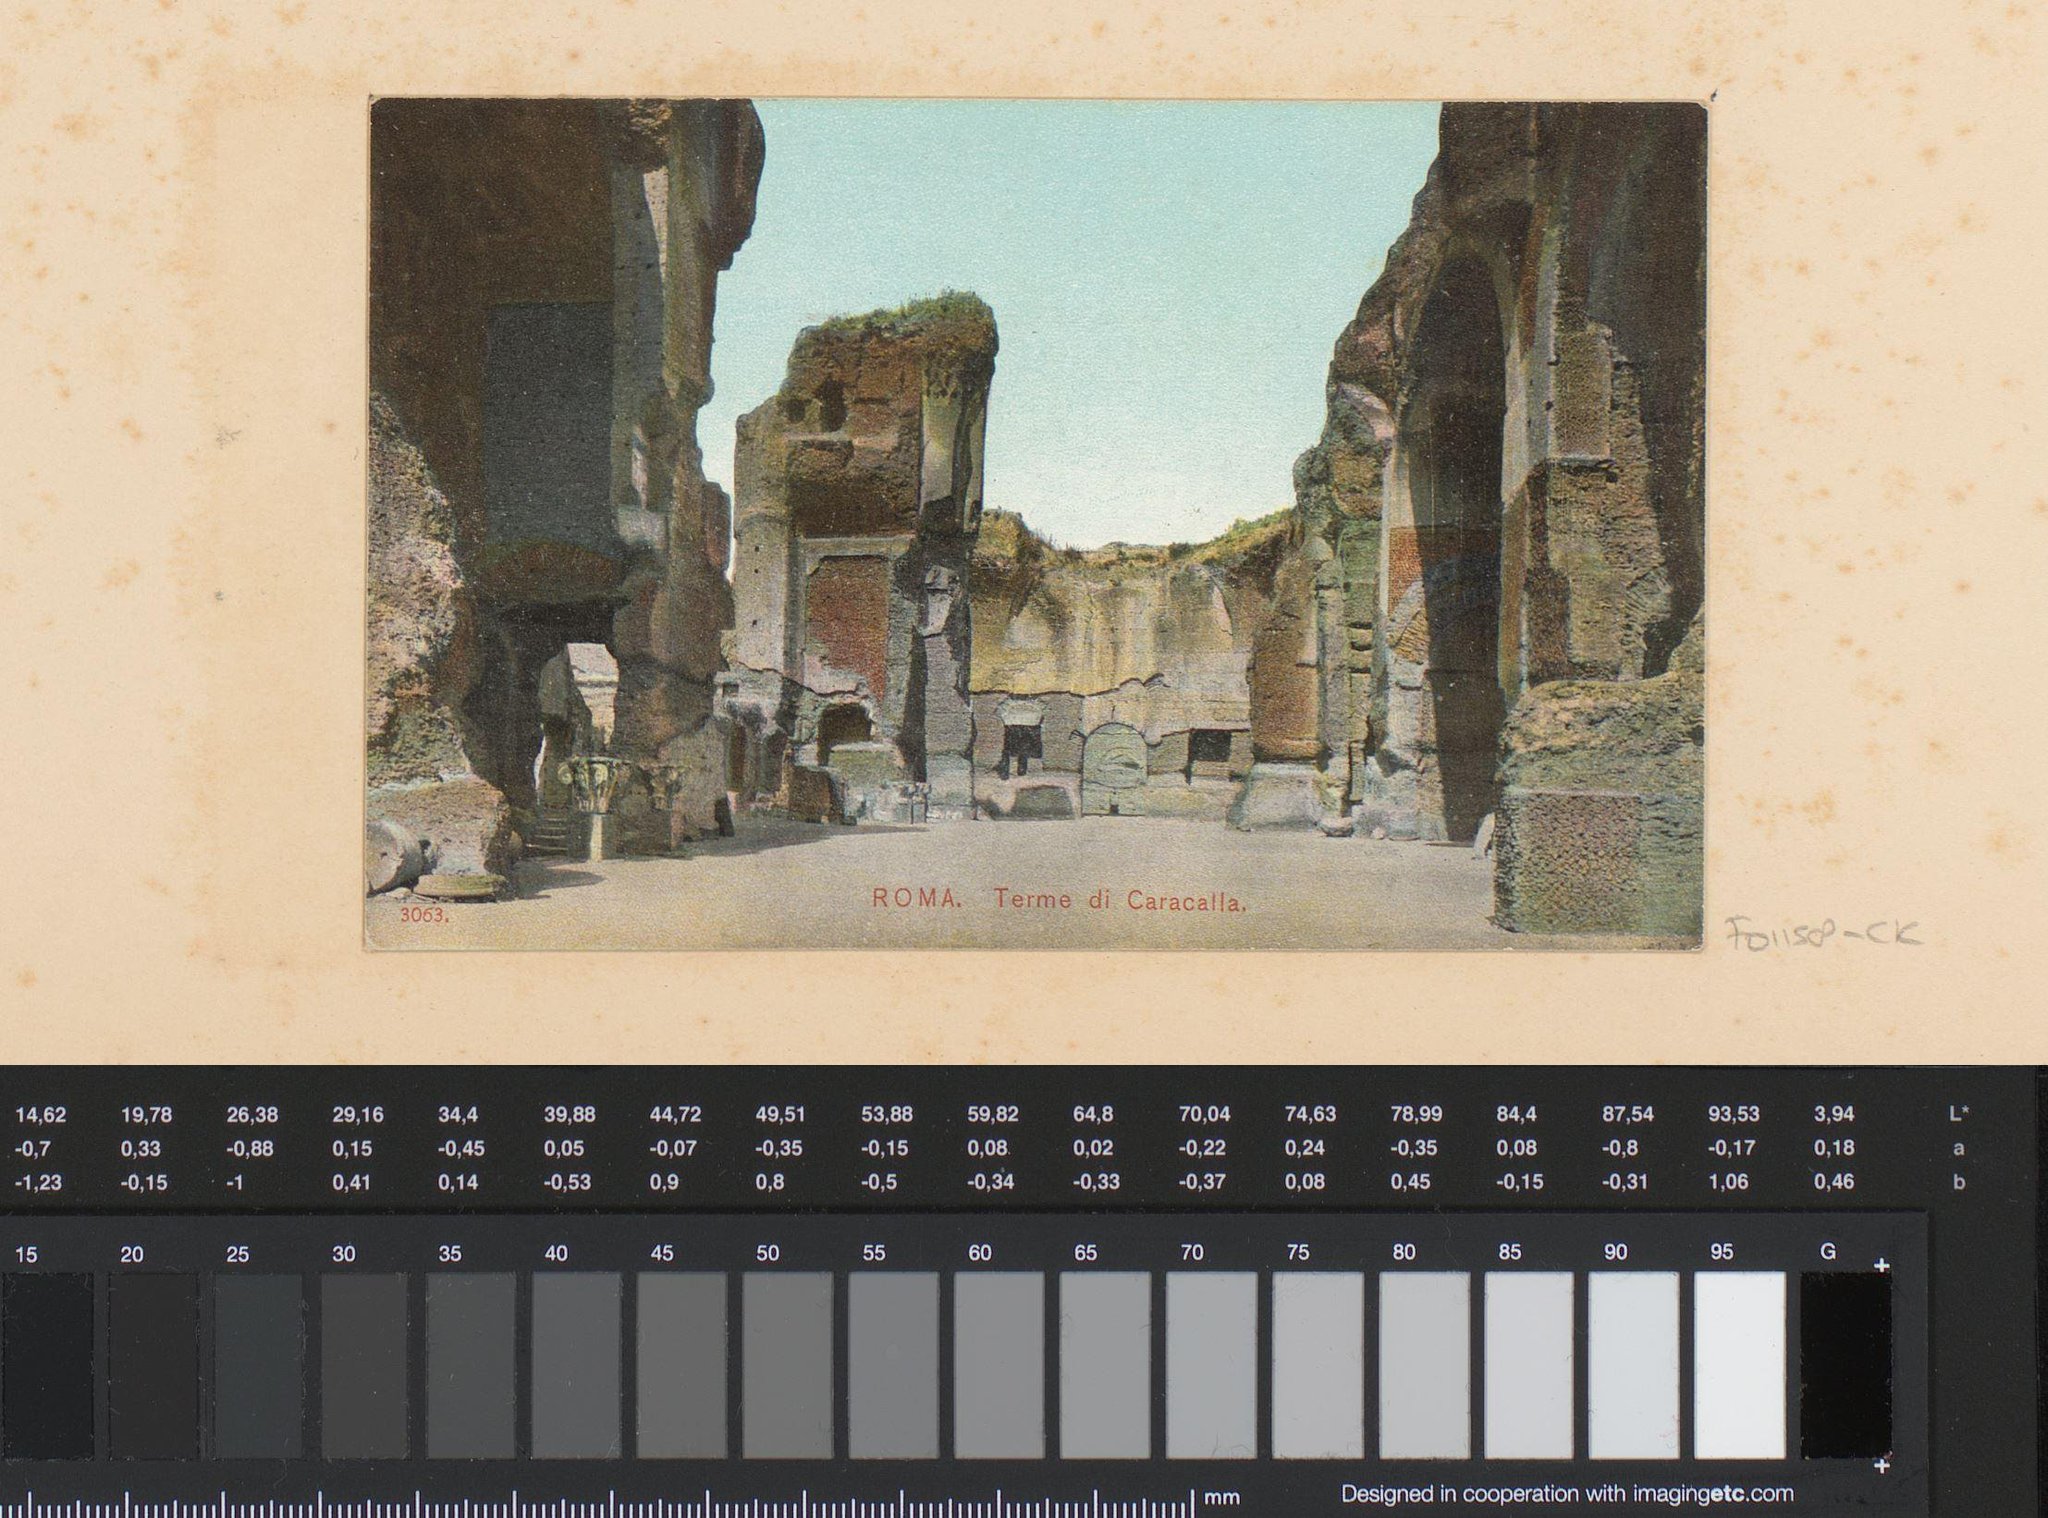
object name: ansichtkaart, prentbriefkaart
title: Roma. Terme di Caracalla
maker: Anonymous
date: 1875-1907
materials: paper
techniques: color autotype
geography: rome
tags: ruin of a building ~ architecture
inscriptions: number: ‘3063’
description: Onderdeel van Fotoalbum met opnames van bezienswaardigheden en kunstwerken in Italië.